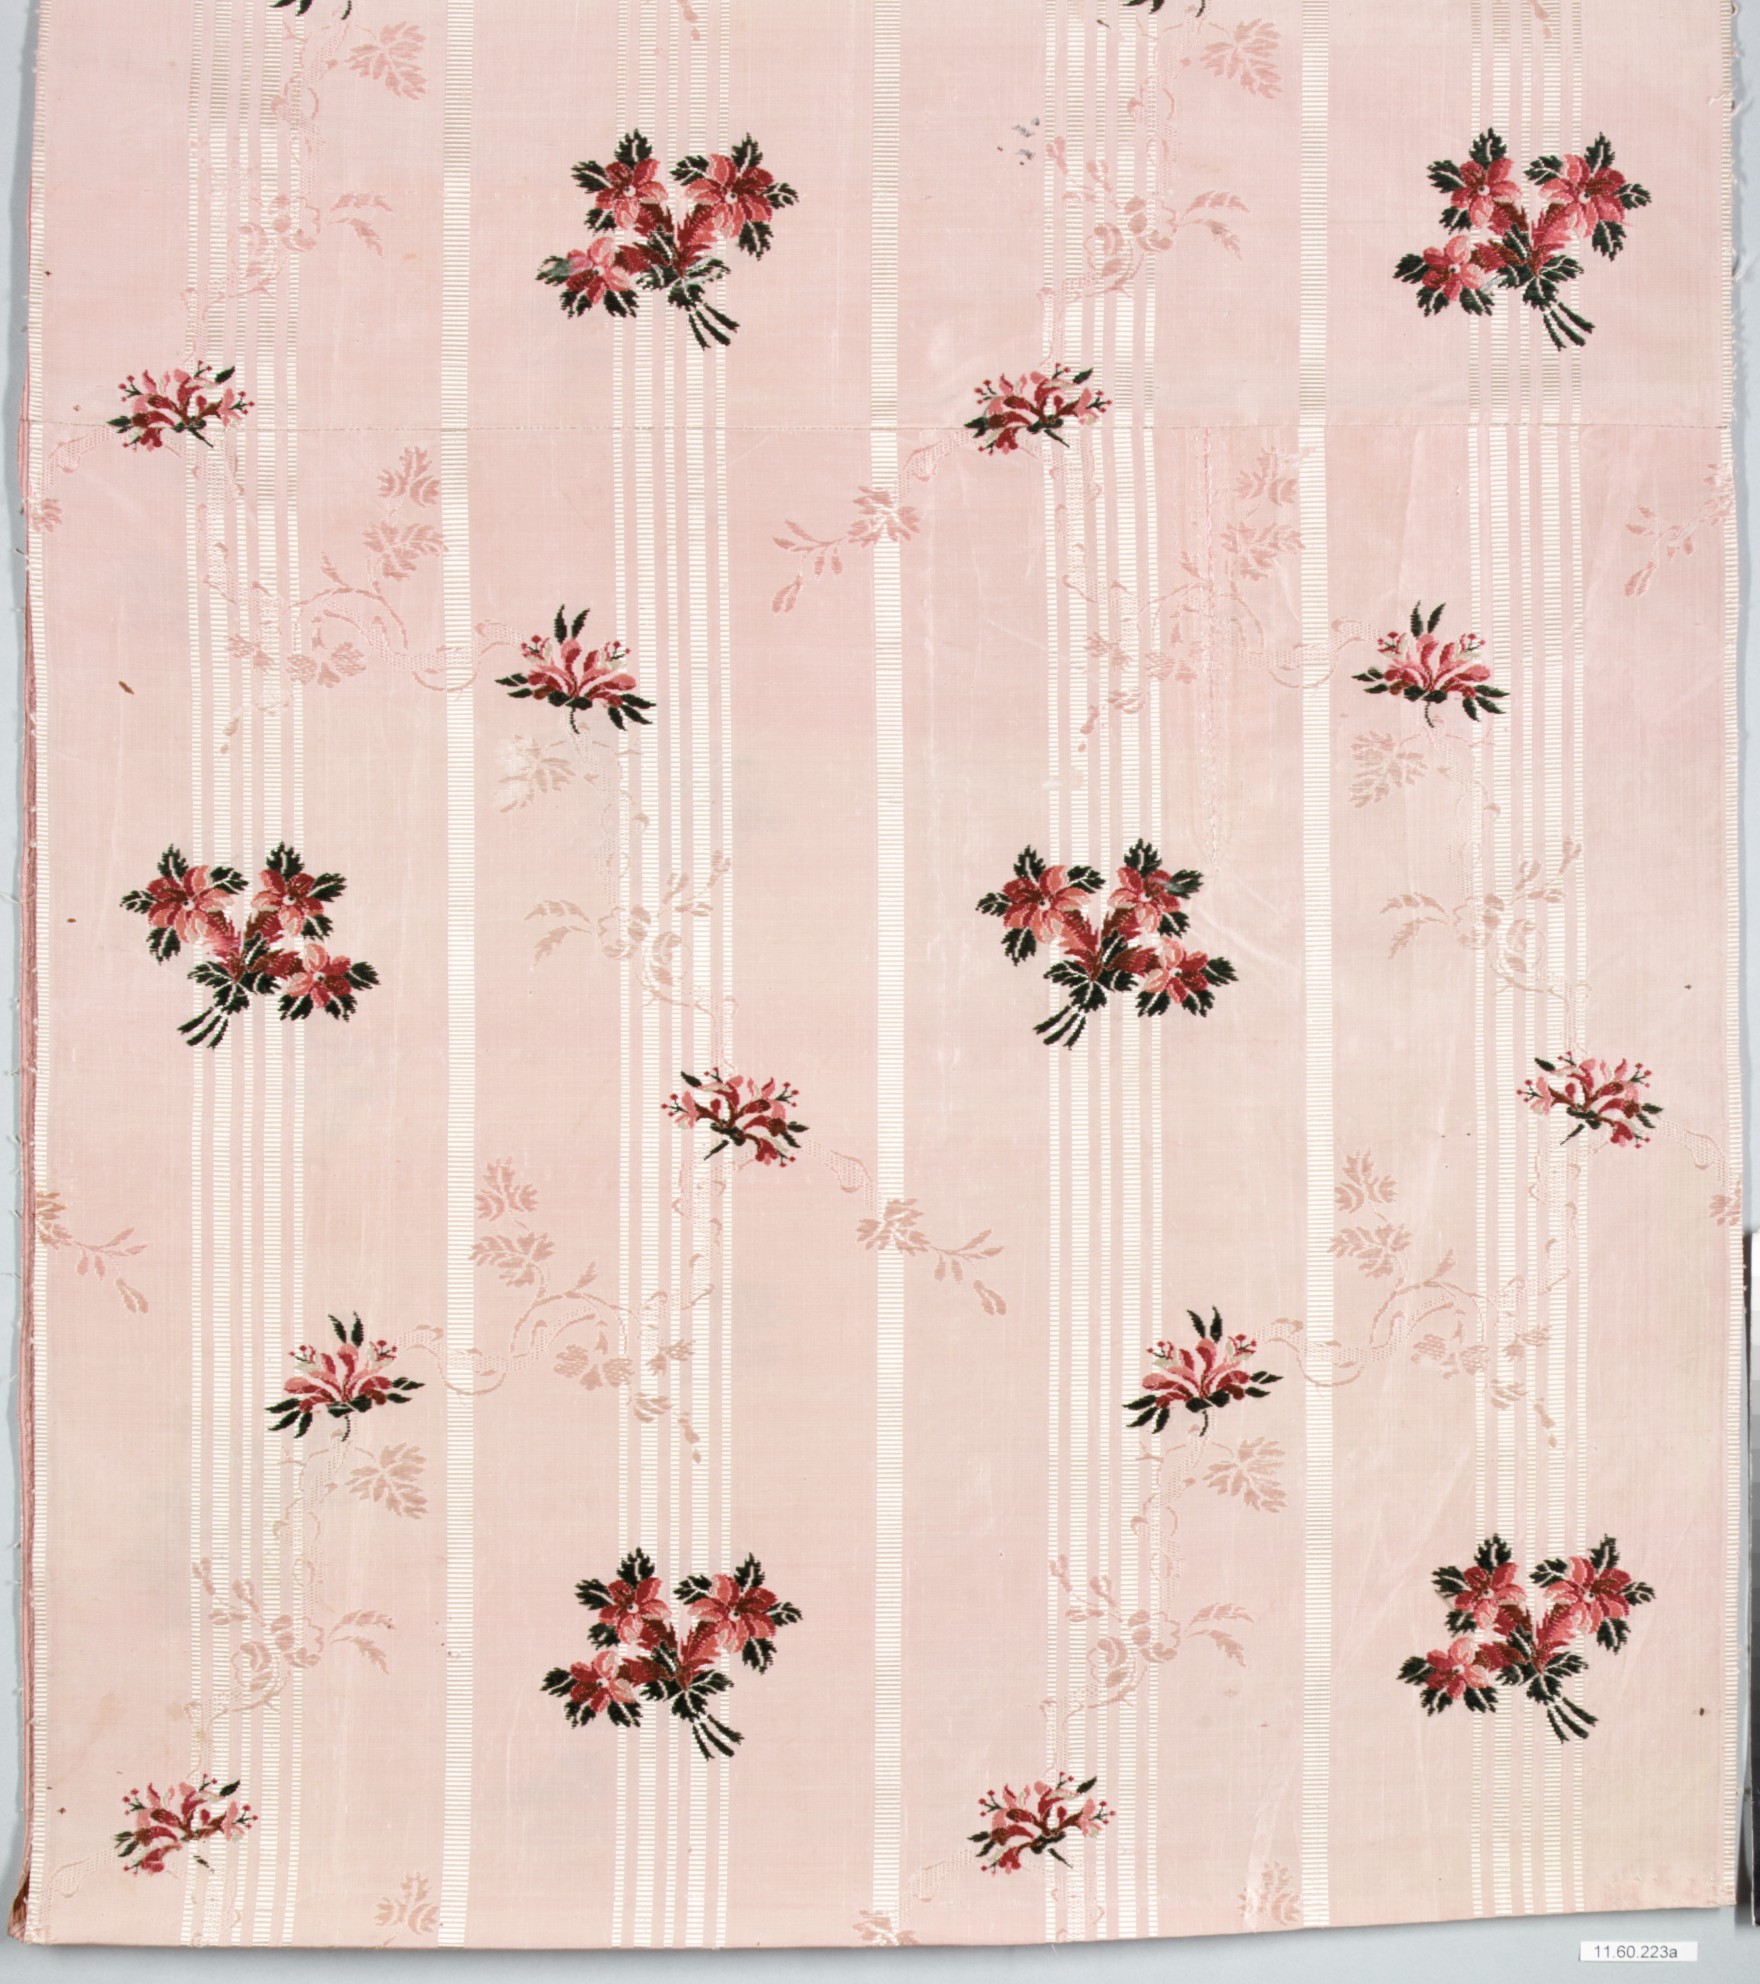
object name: panel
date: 1774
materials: silk